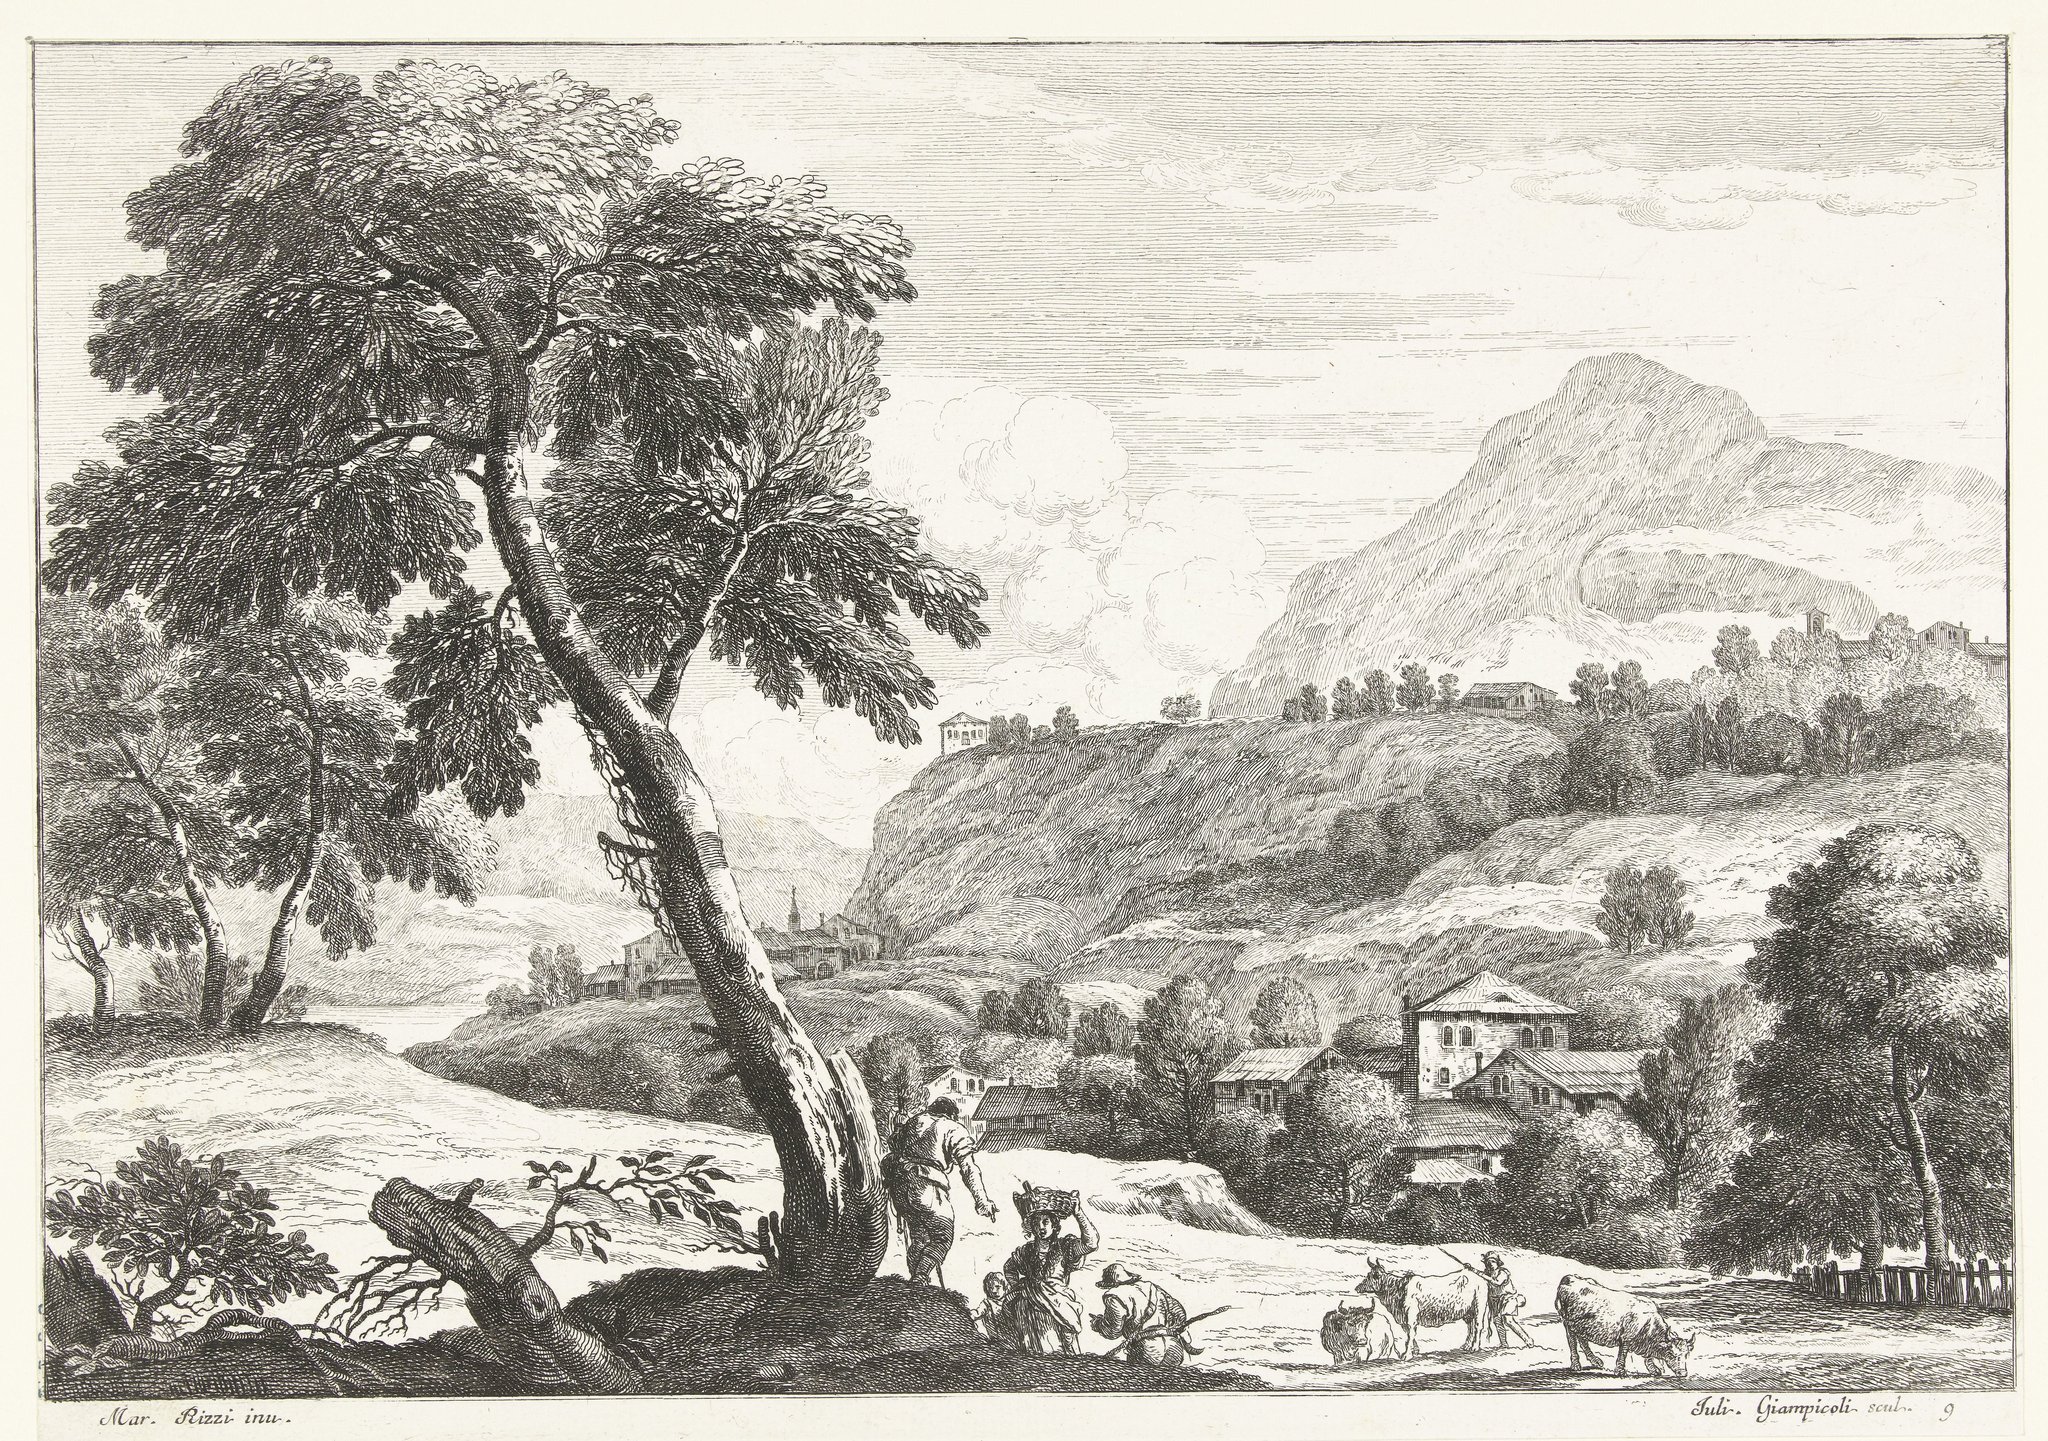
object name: print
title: Heuvellandschap met enkele figuren bij boom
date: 1739-1740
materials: paper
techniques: etching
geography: venice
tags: mountains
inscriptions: collector's mark: Lugt 2228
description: Prent uit eerste serie van achttien prenten met Italiaanse landschappen naar ontwerp van Marco Ricci en titelprent (zie RP-P-1952-20) opgedragen aan consul Joseph Smith.